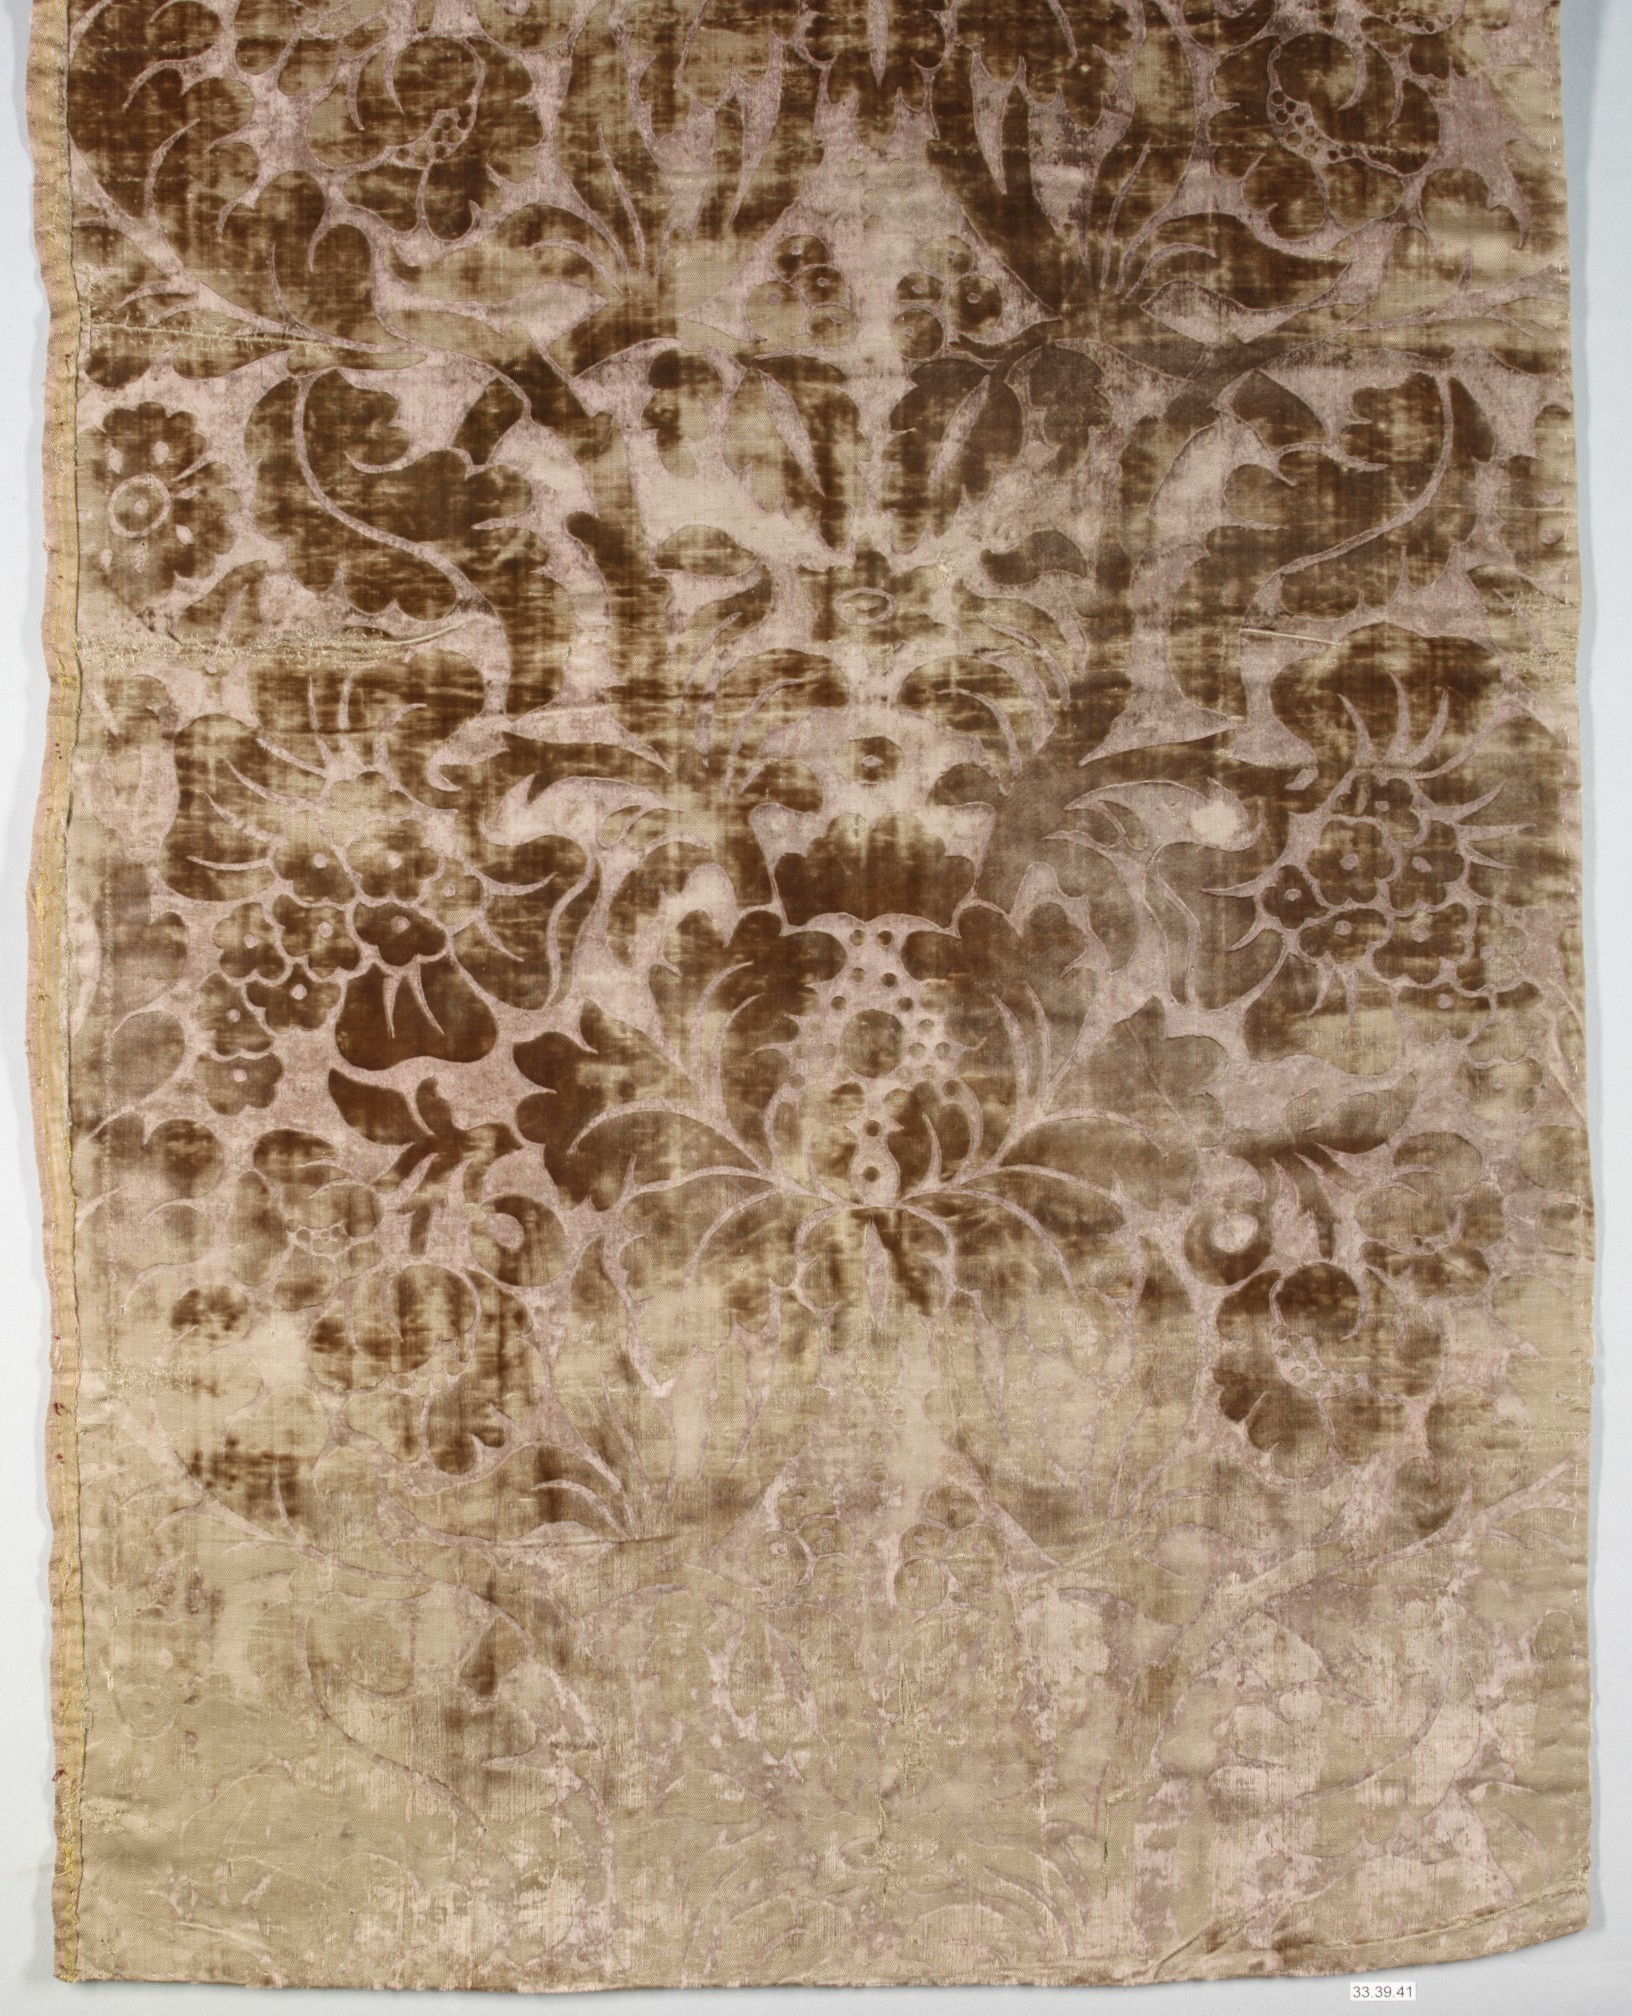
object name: piece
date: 1601-1700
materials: silk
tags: flowers